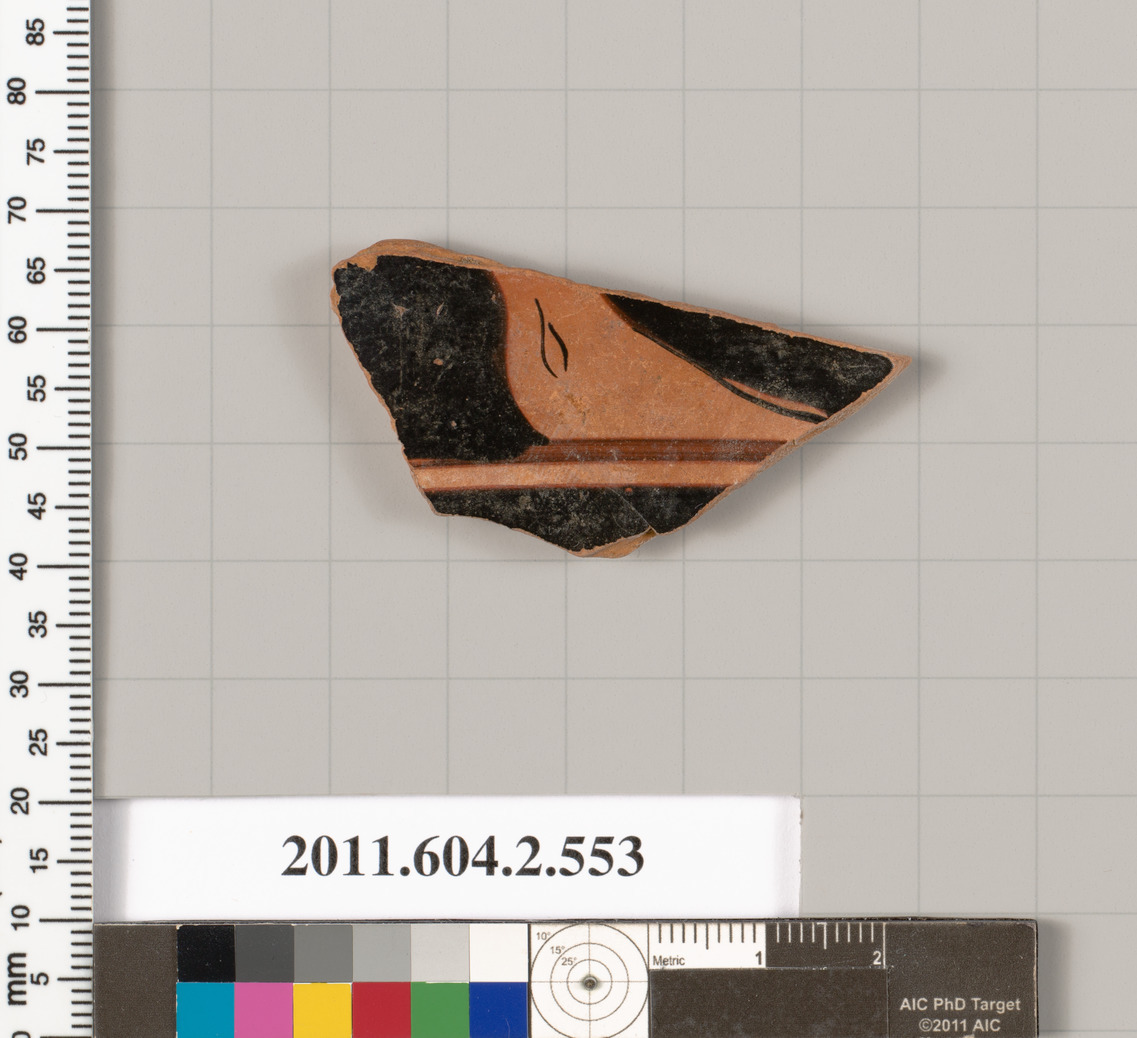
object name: column krater fragment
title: Terracotta fragment of a column-krater (bowl for mixing wine and water)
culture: greek, attic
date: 460-440 BCE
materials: terracotta